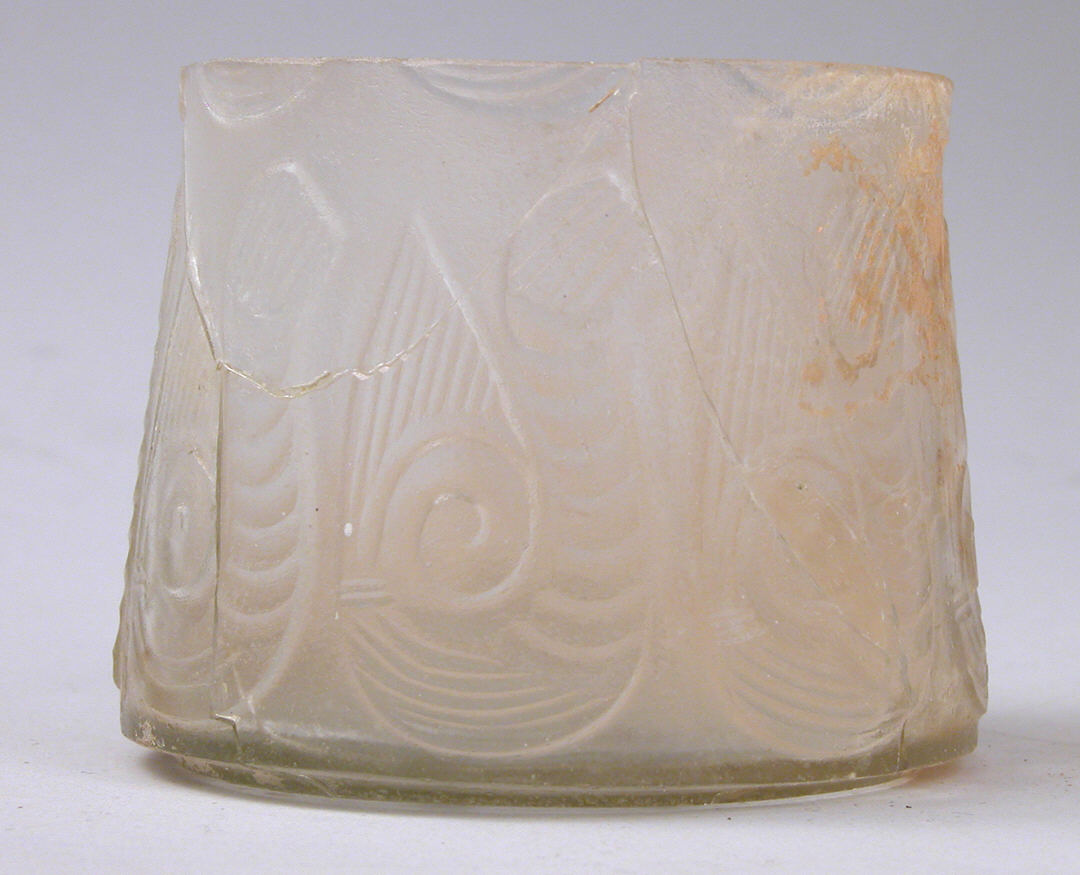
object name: cup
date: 901-1100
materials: glass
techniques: cutting, glassblowing, relief, tooling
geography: iran